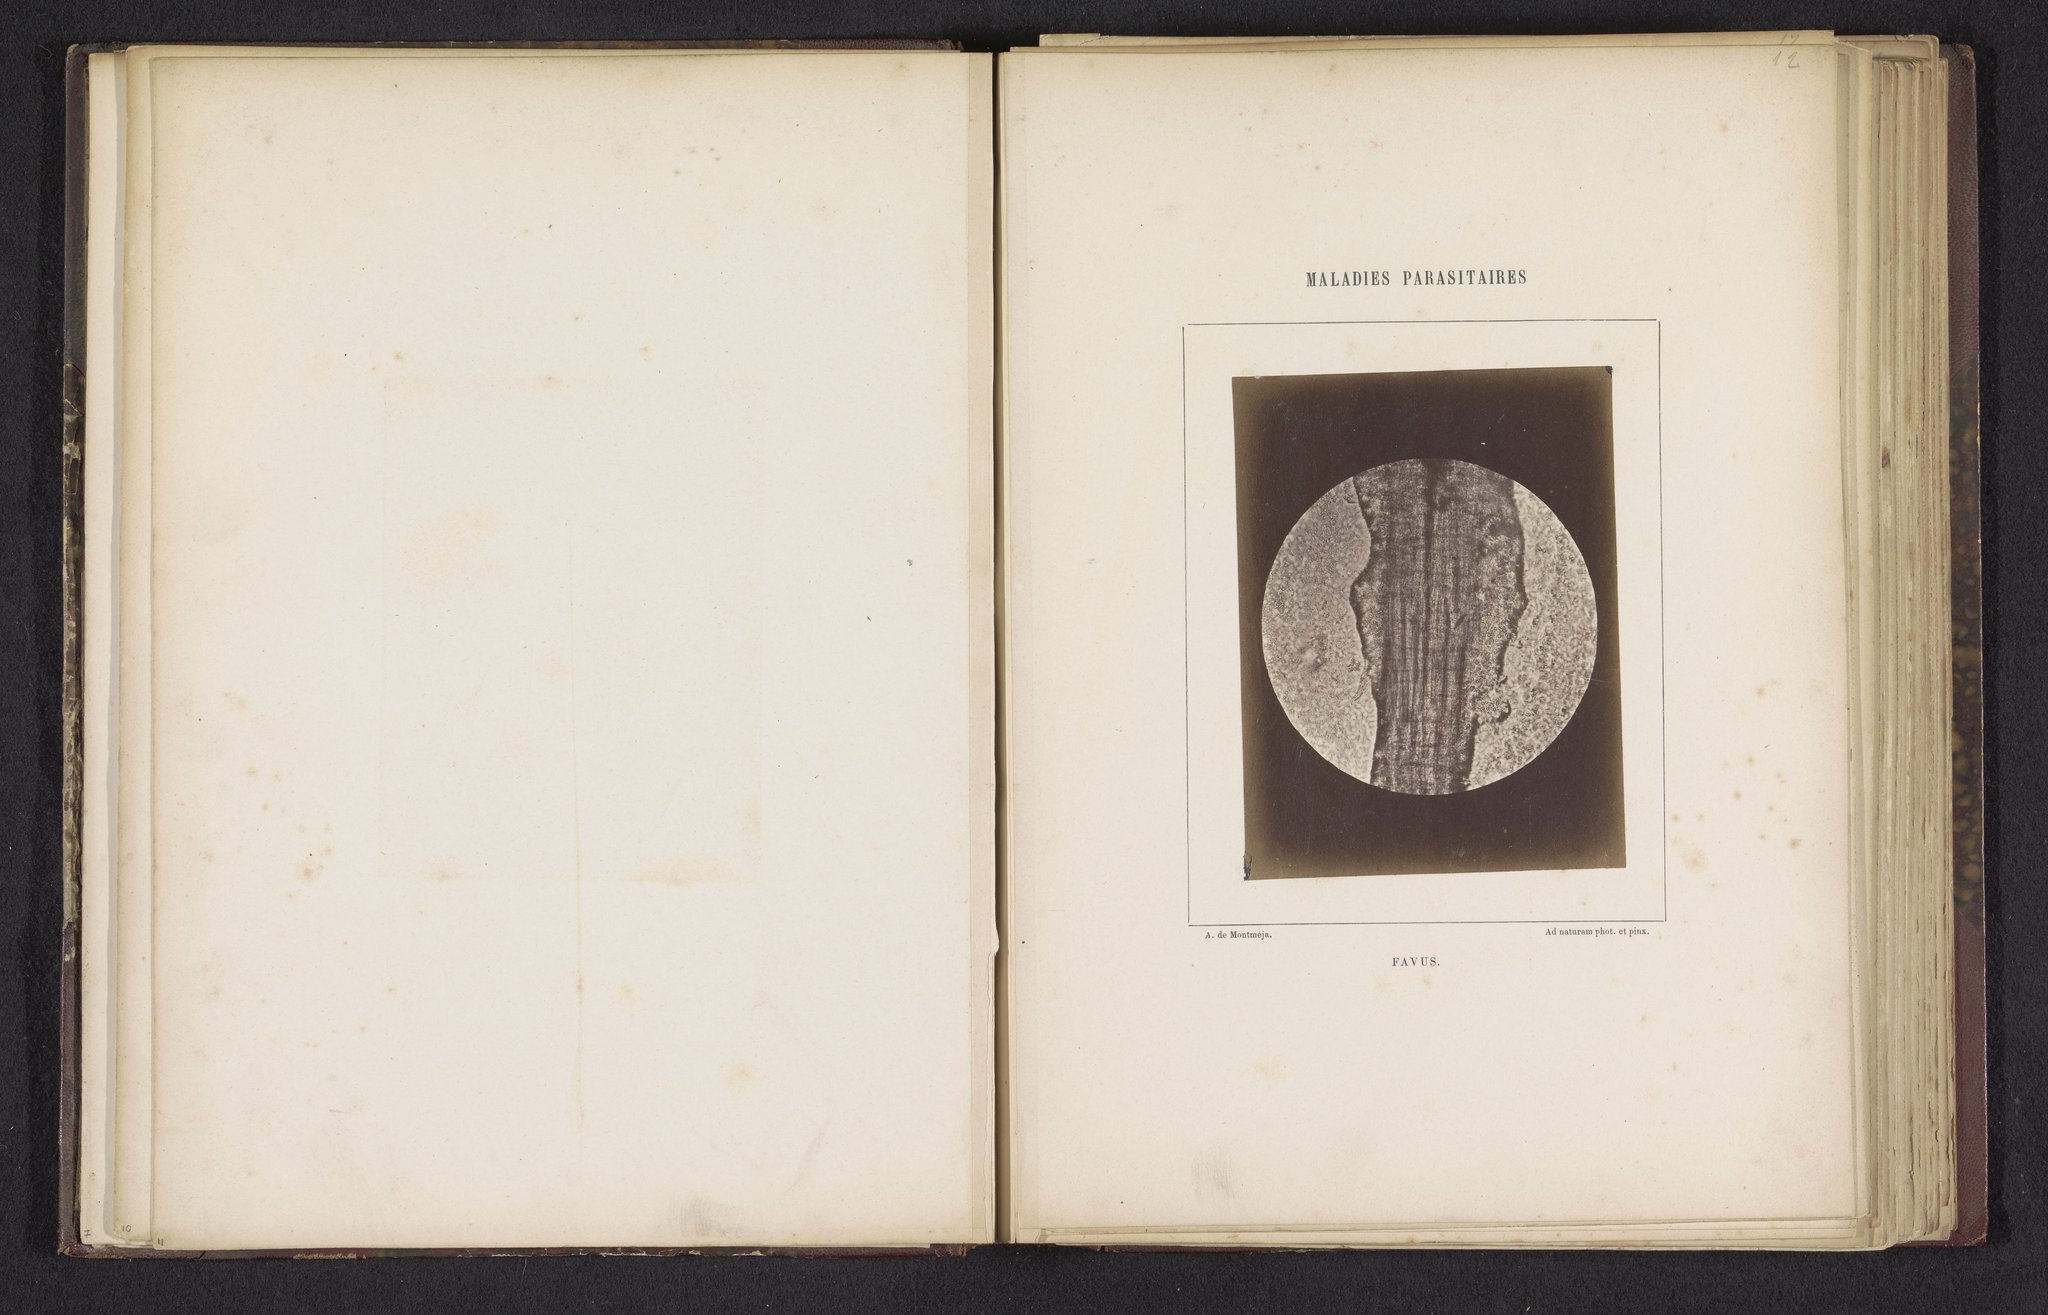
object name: photograph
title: Favus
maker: a. de montméja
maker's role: arts, fotograaf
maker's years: 1841-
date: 1860-1868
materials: photographic support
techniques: albumen print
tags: skin and venereal diseases, microscope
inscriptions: number: ‘12’, inscription: ‘Ad naturam phot. et pinx.’, inscription: ‘Maladies parasitaires’